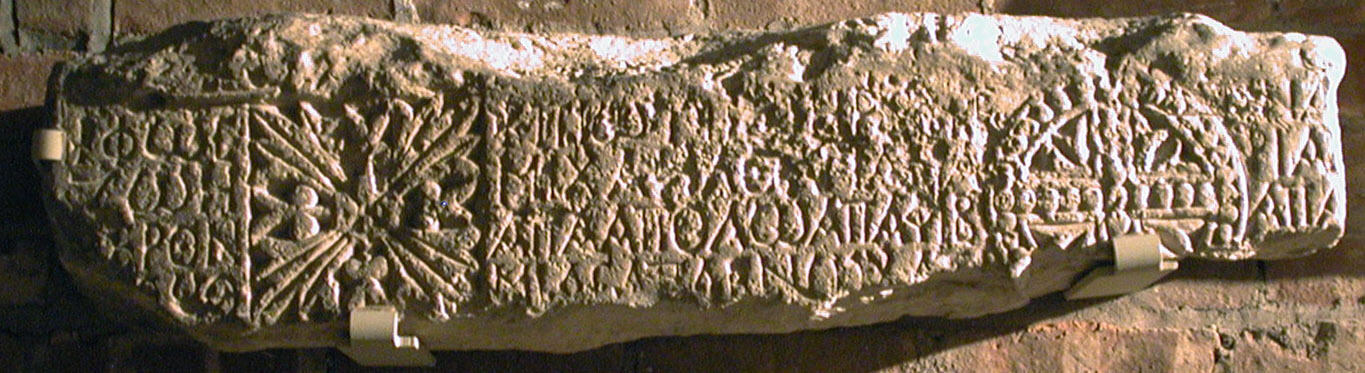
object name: fragment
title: Fragment from a Lintel or Frieze with a Foliate Square and Circle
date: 501-700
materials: limestone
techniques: carving, relief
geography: egypt